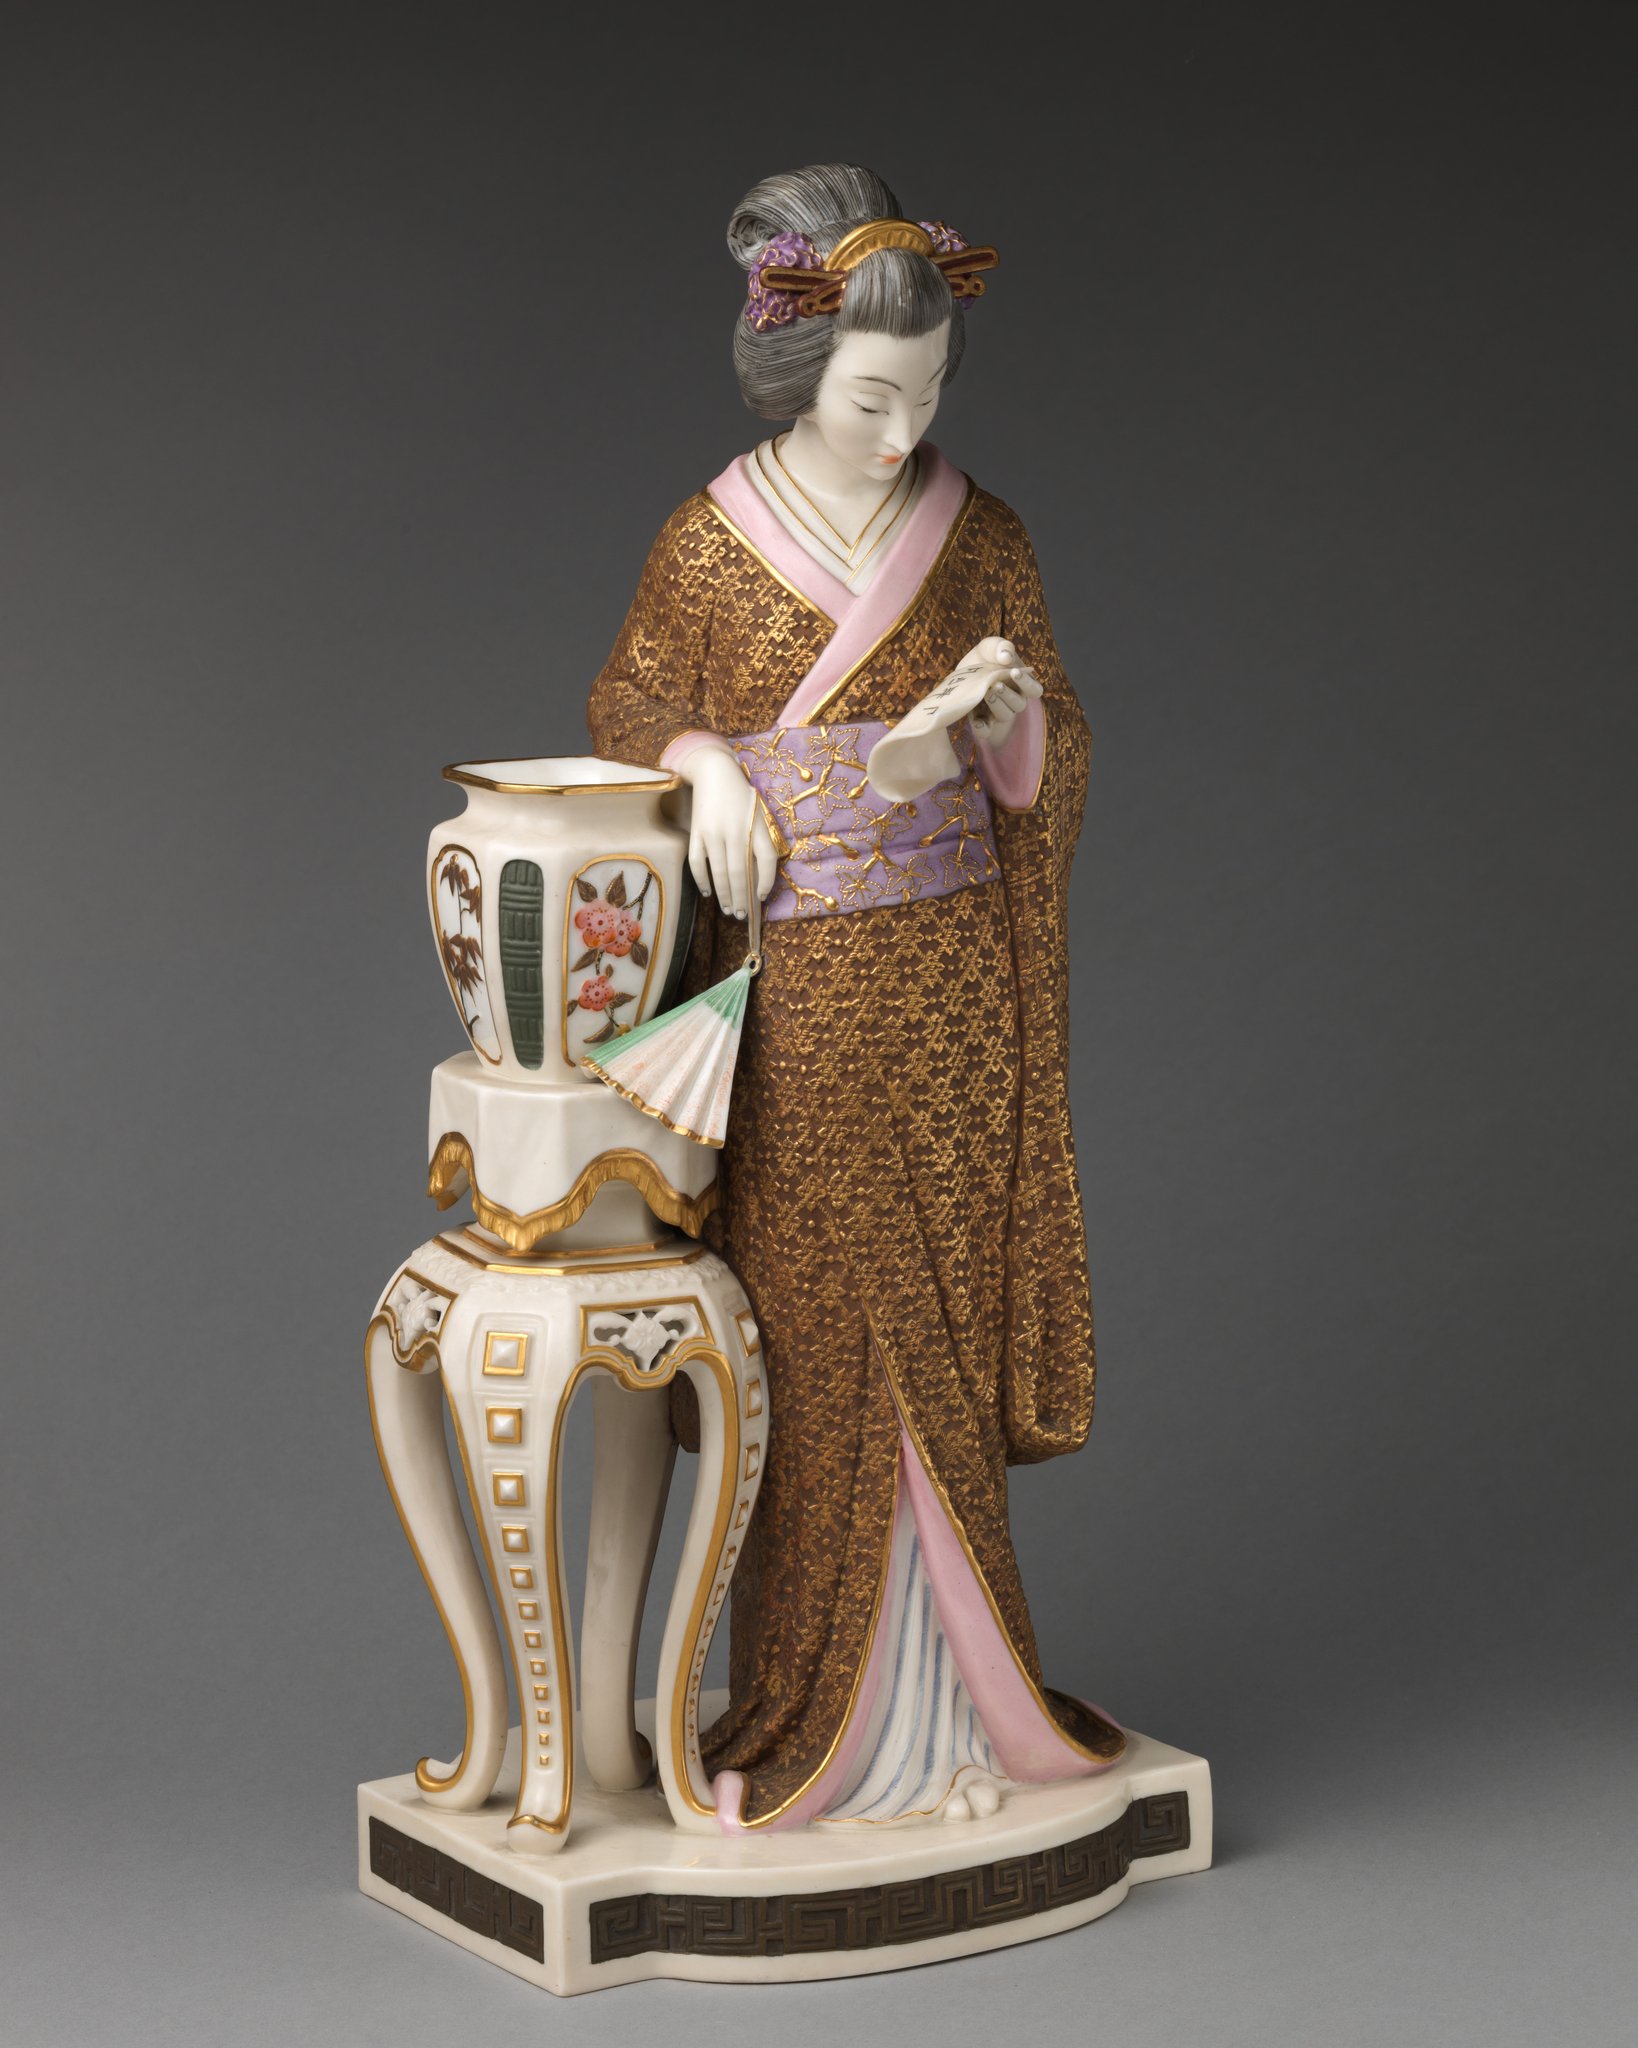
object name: figure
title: Figure of Japanese woman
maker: james hadley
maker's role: modeler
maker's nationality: british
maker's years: 1837-1903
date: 1879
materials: bone china, enamel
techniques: gilding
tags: women,reading